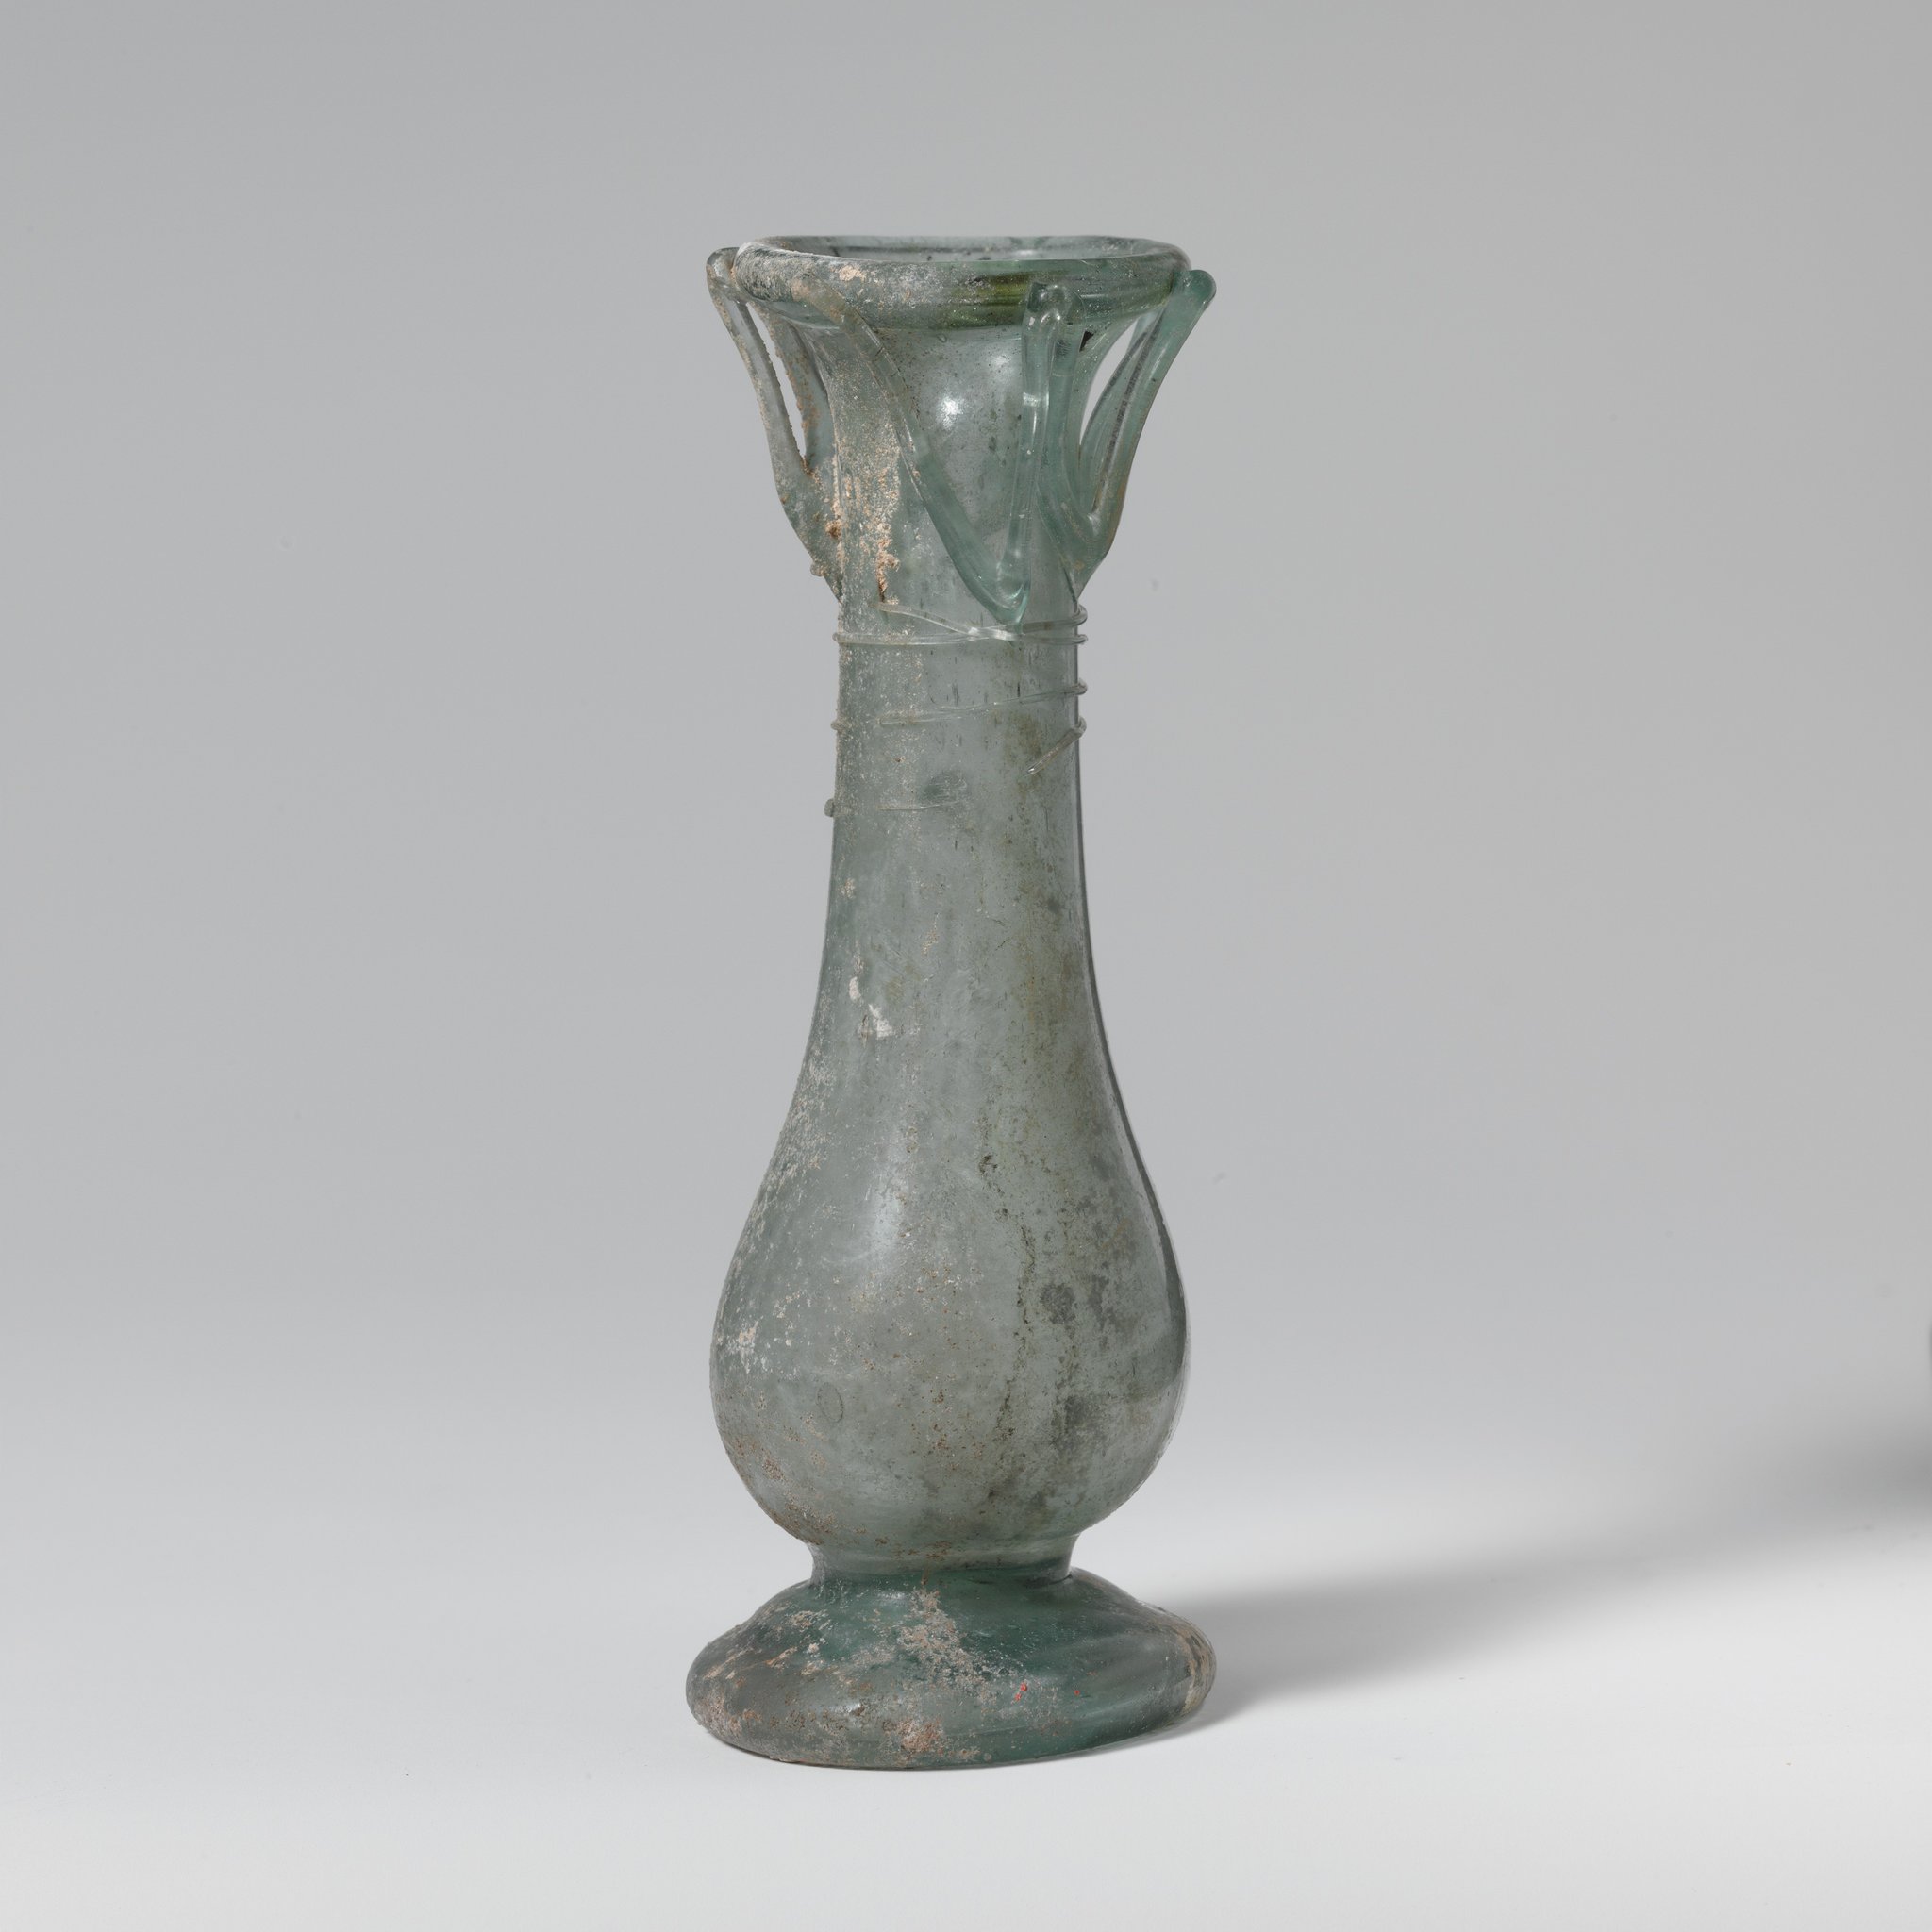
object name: cosmetic flask, single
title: Glass cosmetic flask (kohl tube)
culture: roman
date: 201-400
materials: glass